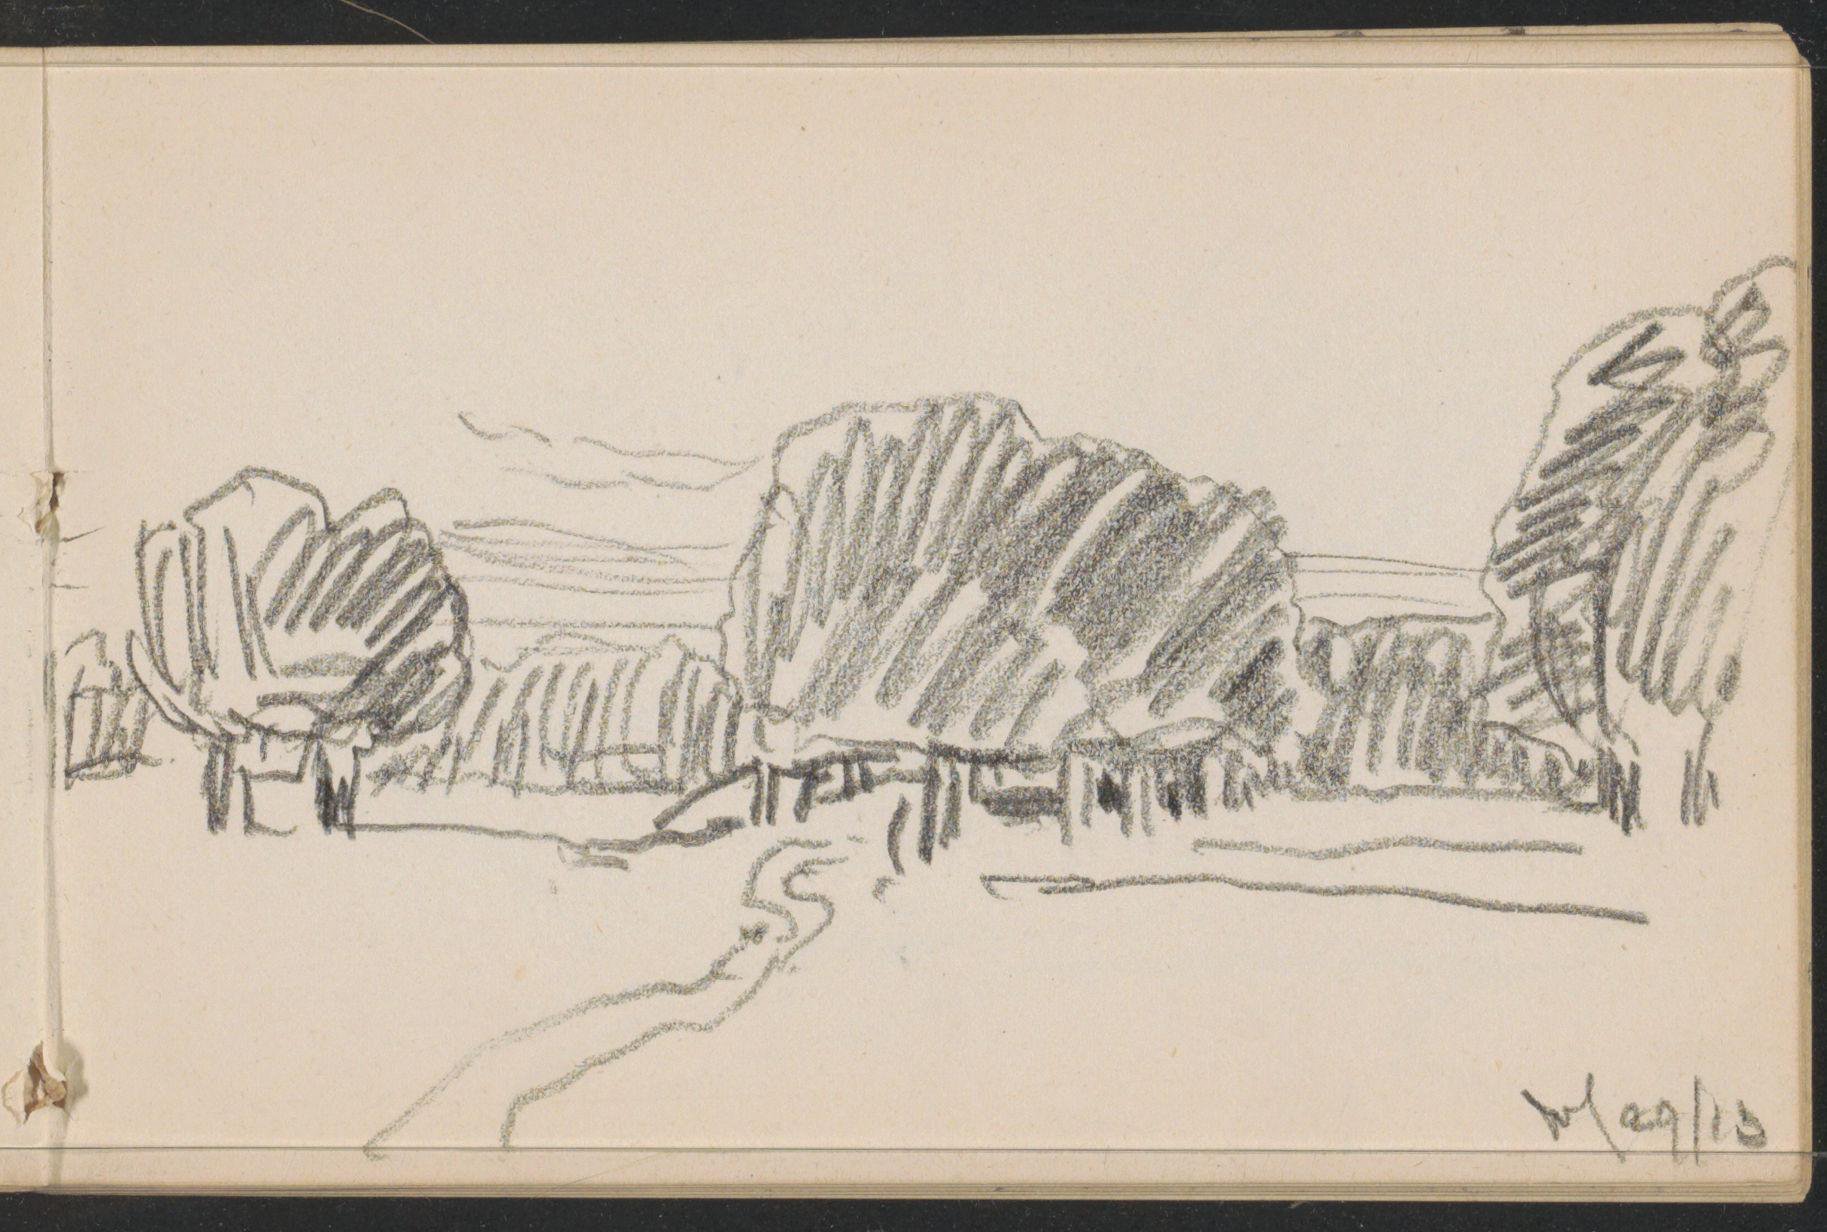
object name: sketchbook leaf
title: Landschap met bomen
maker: alexander shilling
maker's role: draughtsman, print maker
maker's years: 1859-1937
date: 1907-1913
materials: chalk, paper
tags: trees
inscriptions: date: ‘July 29/13’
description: Blad 9 recto uit een schetsboek met 30 bladen.